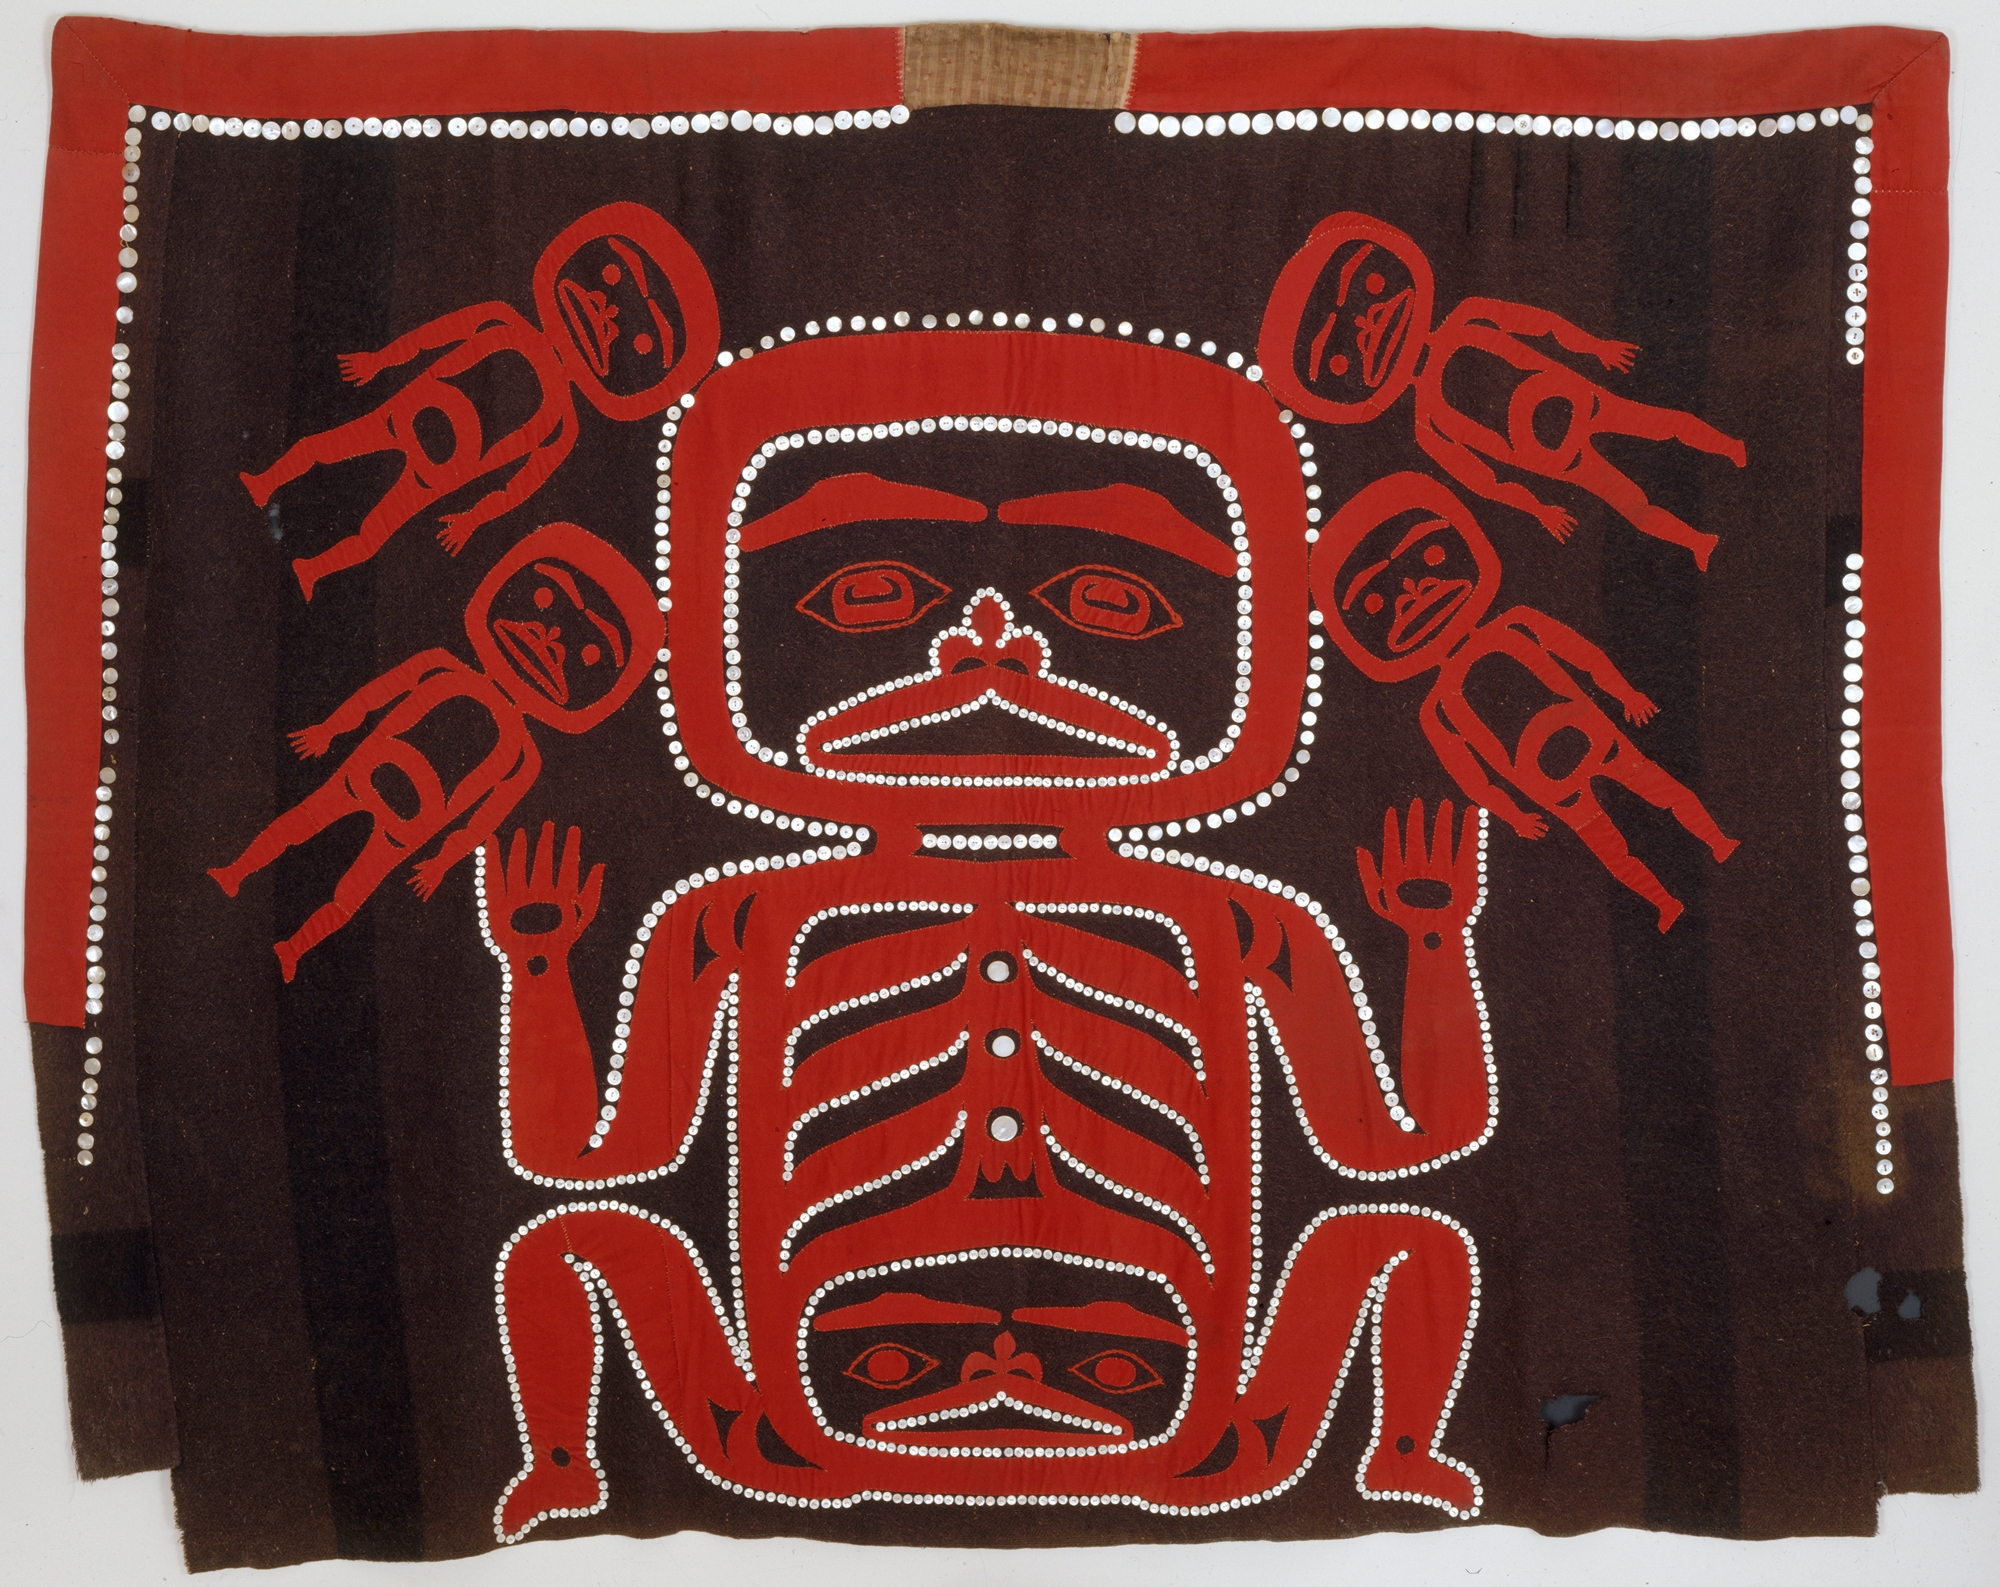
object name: blanket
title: Dance Cape, known as a Button Blanket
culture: tsimshian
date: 1850-1860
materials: textile, shell, wool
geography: canada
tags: human figures,dance